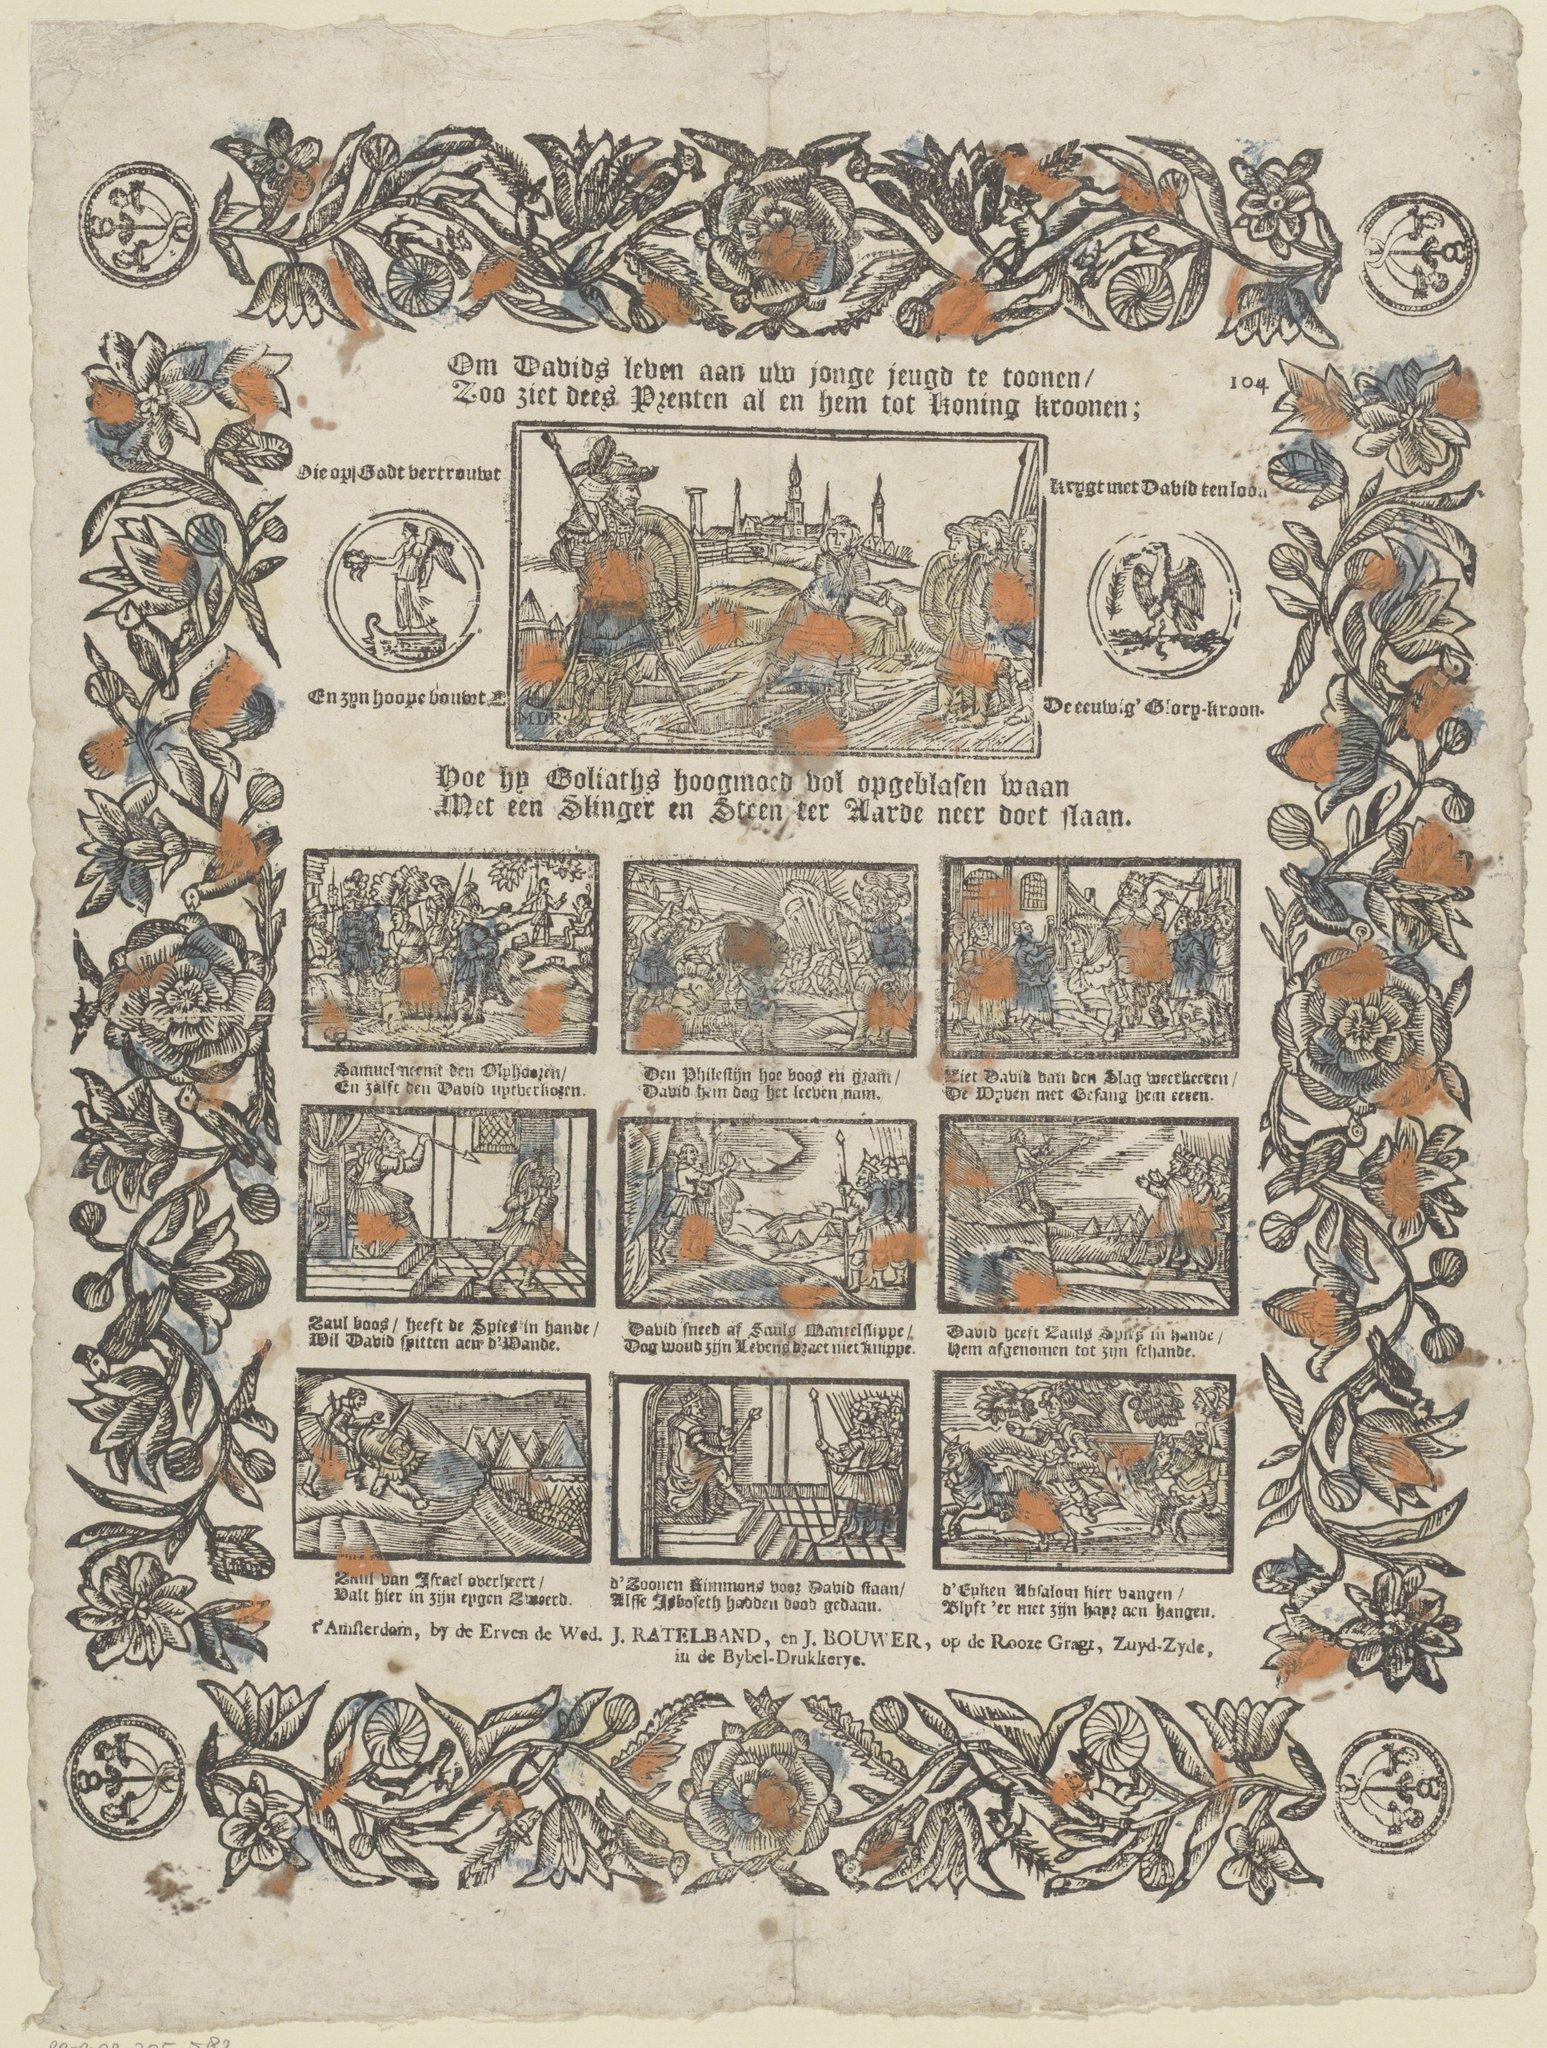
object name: popular print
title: Om Davids leven aan uw jonge jeugd te toonen / Zoo ziet dees prenten al en hem tot koning kroonen; / Hoe hy Goliaths hoogmoed vol opgeblasen waan / Met een slinger en steen ter aarde neer doet slaan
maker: Anonymous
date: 1782-1793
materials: paper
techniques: colour, letterpress printing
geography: amsterdam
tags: story of david, coin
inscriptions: collector's mark: Lugt 2760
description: Blad met 12 voorstellingen uit het verhaal van de oudtestamentische koning David en twee munten. Onder elke voorstelling een onderschrift. Geheel gevat in een sierlijst van bloemenranken, dieren en munten. Genummerd rechtsboven: 104.